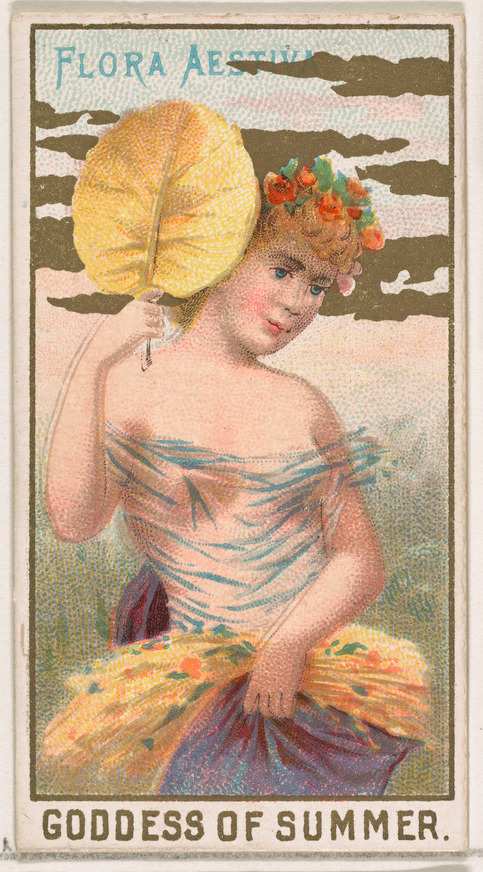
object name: print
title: Flora Aestiva, Goddess of Summer, from the Goddesses of the Greeks and Romans series (N188) issued by Wm. S. Kimball & Co.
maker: william s. kimball & company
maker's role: publisher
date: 1889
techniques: color lithograph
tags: fans,goddess